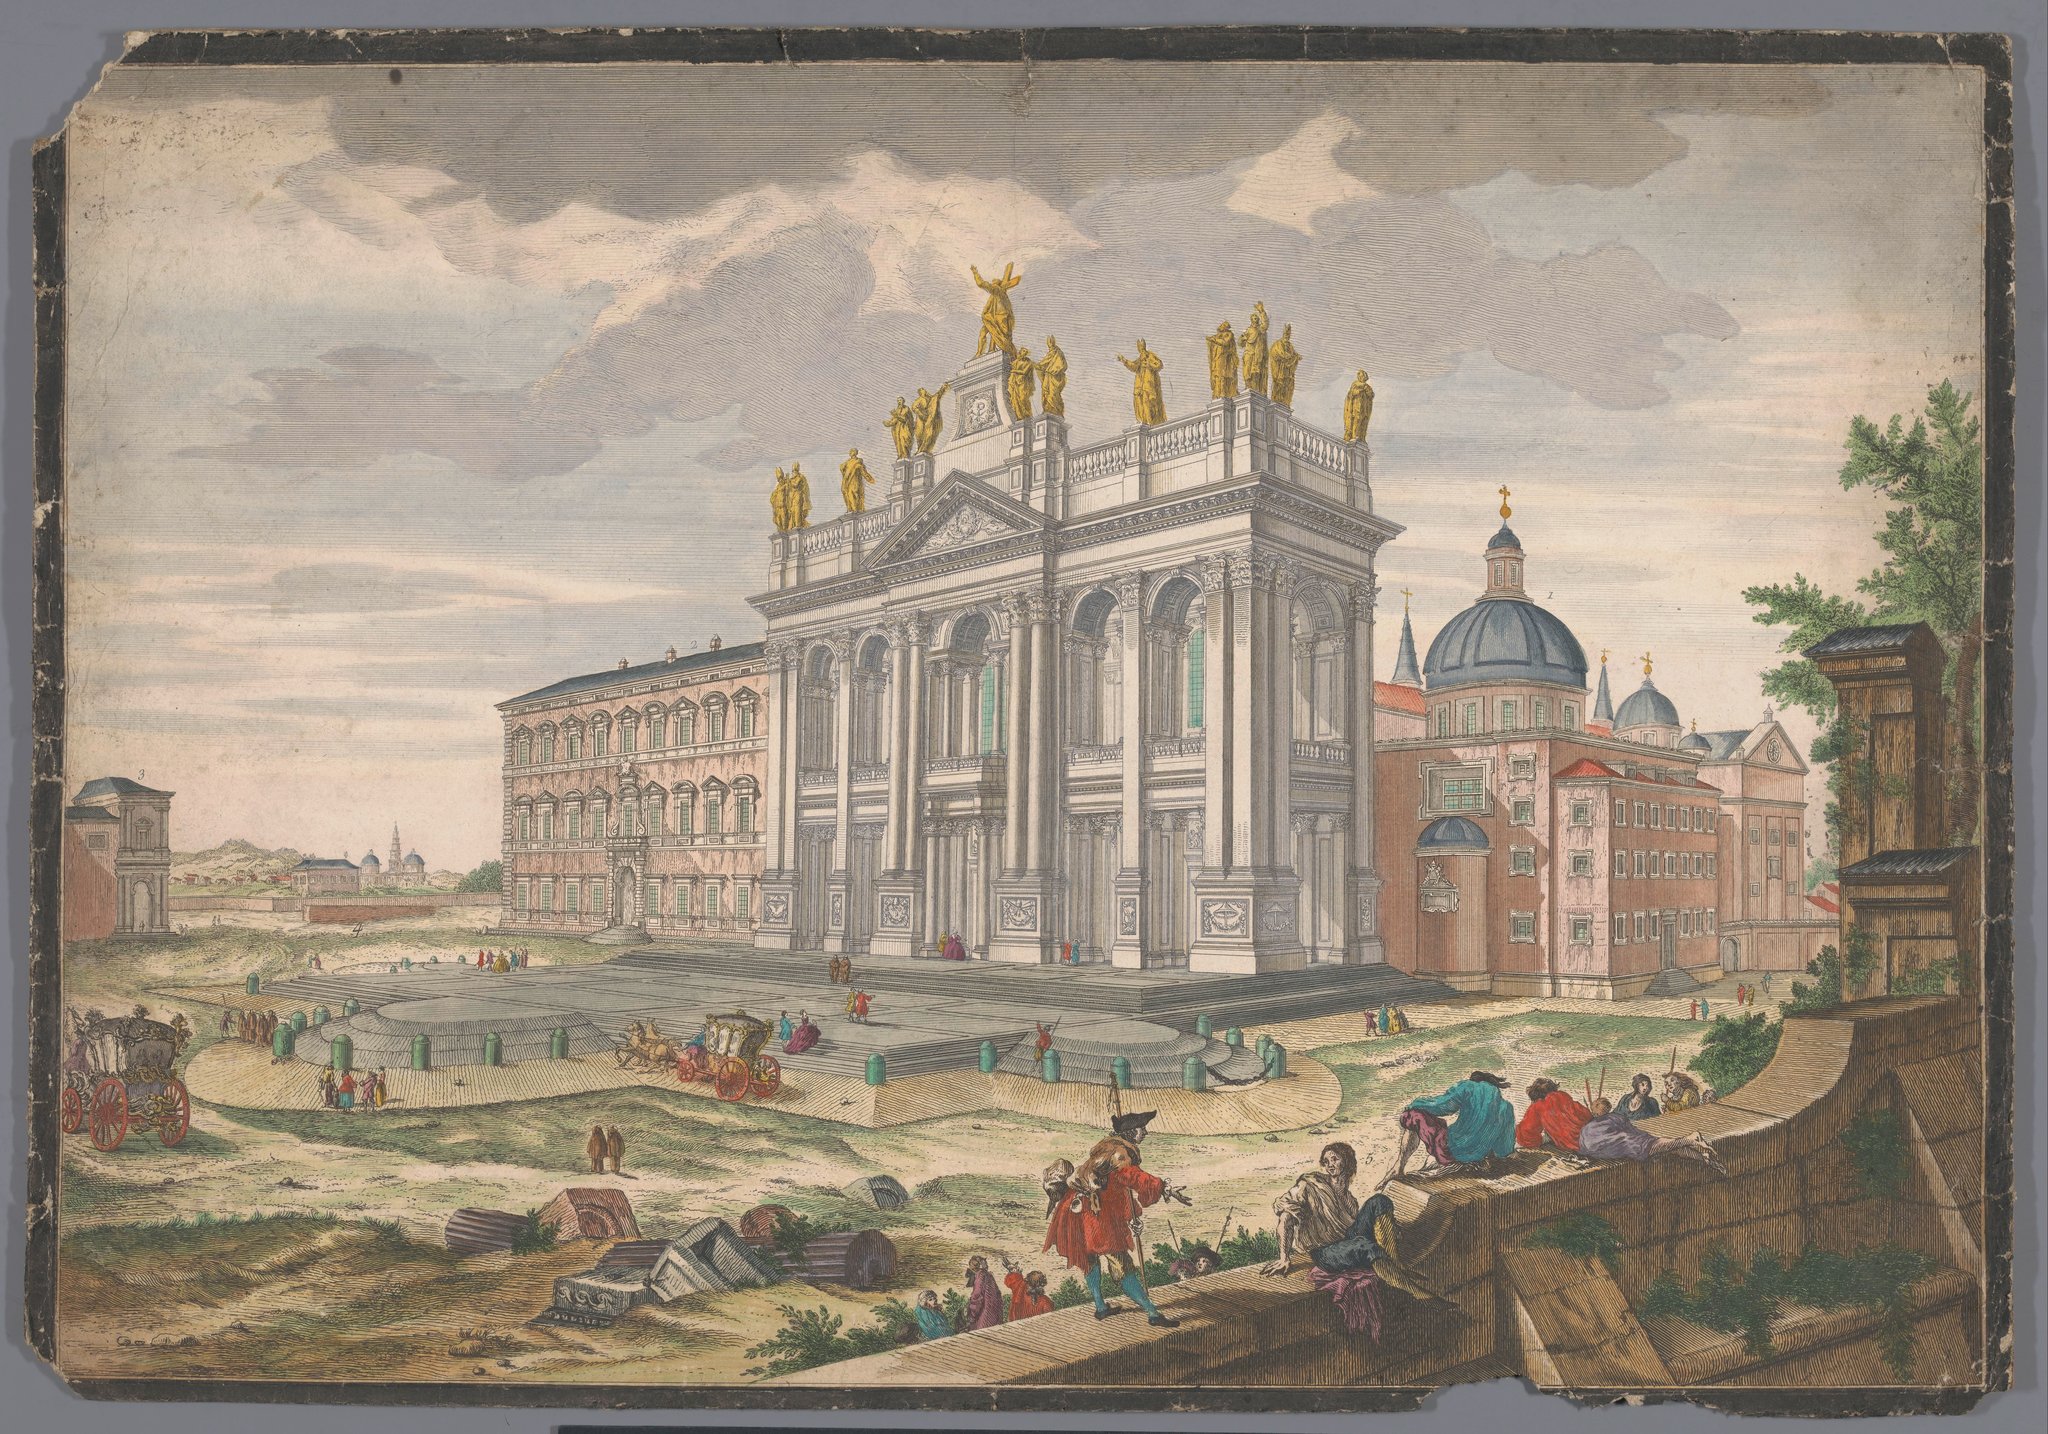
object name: print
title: Gezicht op de kerk Sint-Jan van Lateranen te Rome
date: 1700-1799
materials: cardboard, paper, watercolor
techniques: brush, etching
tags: church (exterior), street (+ city(-scape) with figures, staffage)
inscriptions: collector's mark: Lugt 2233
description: In de ondermarge een verklarende lijst met nummers.